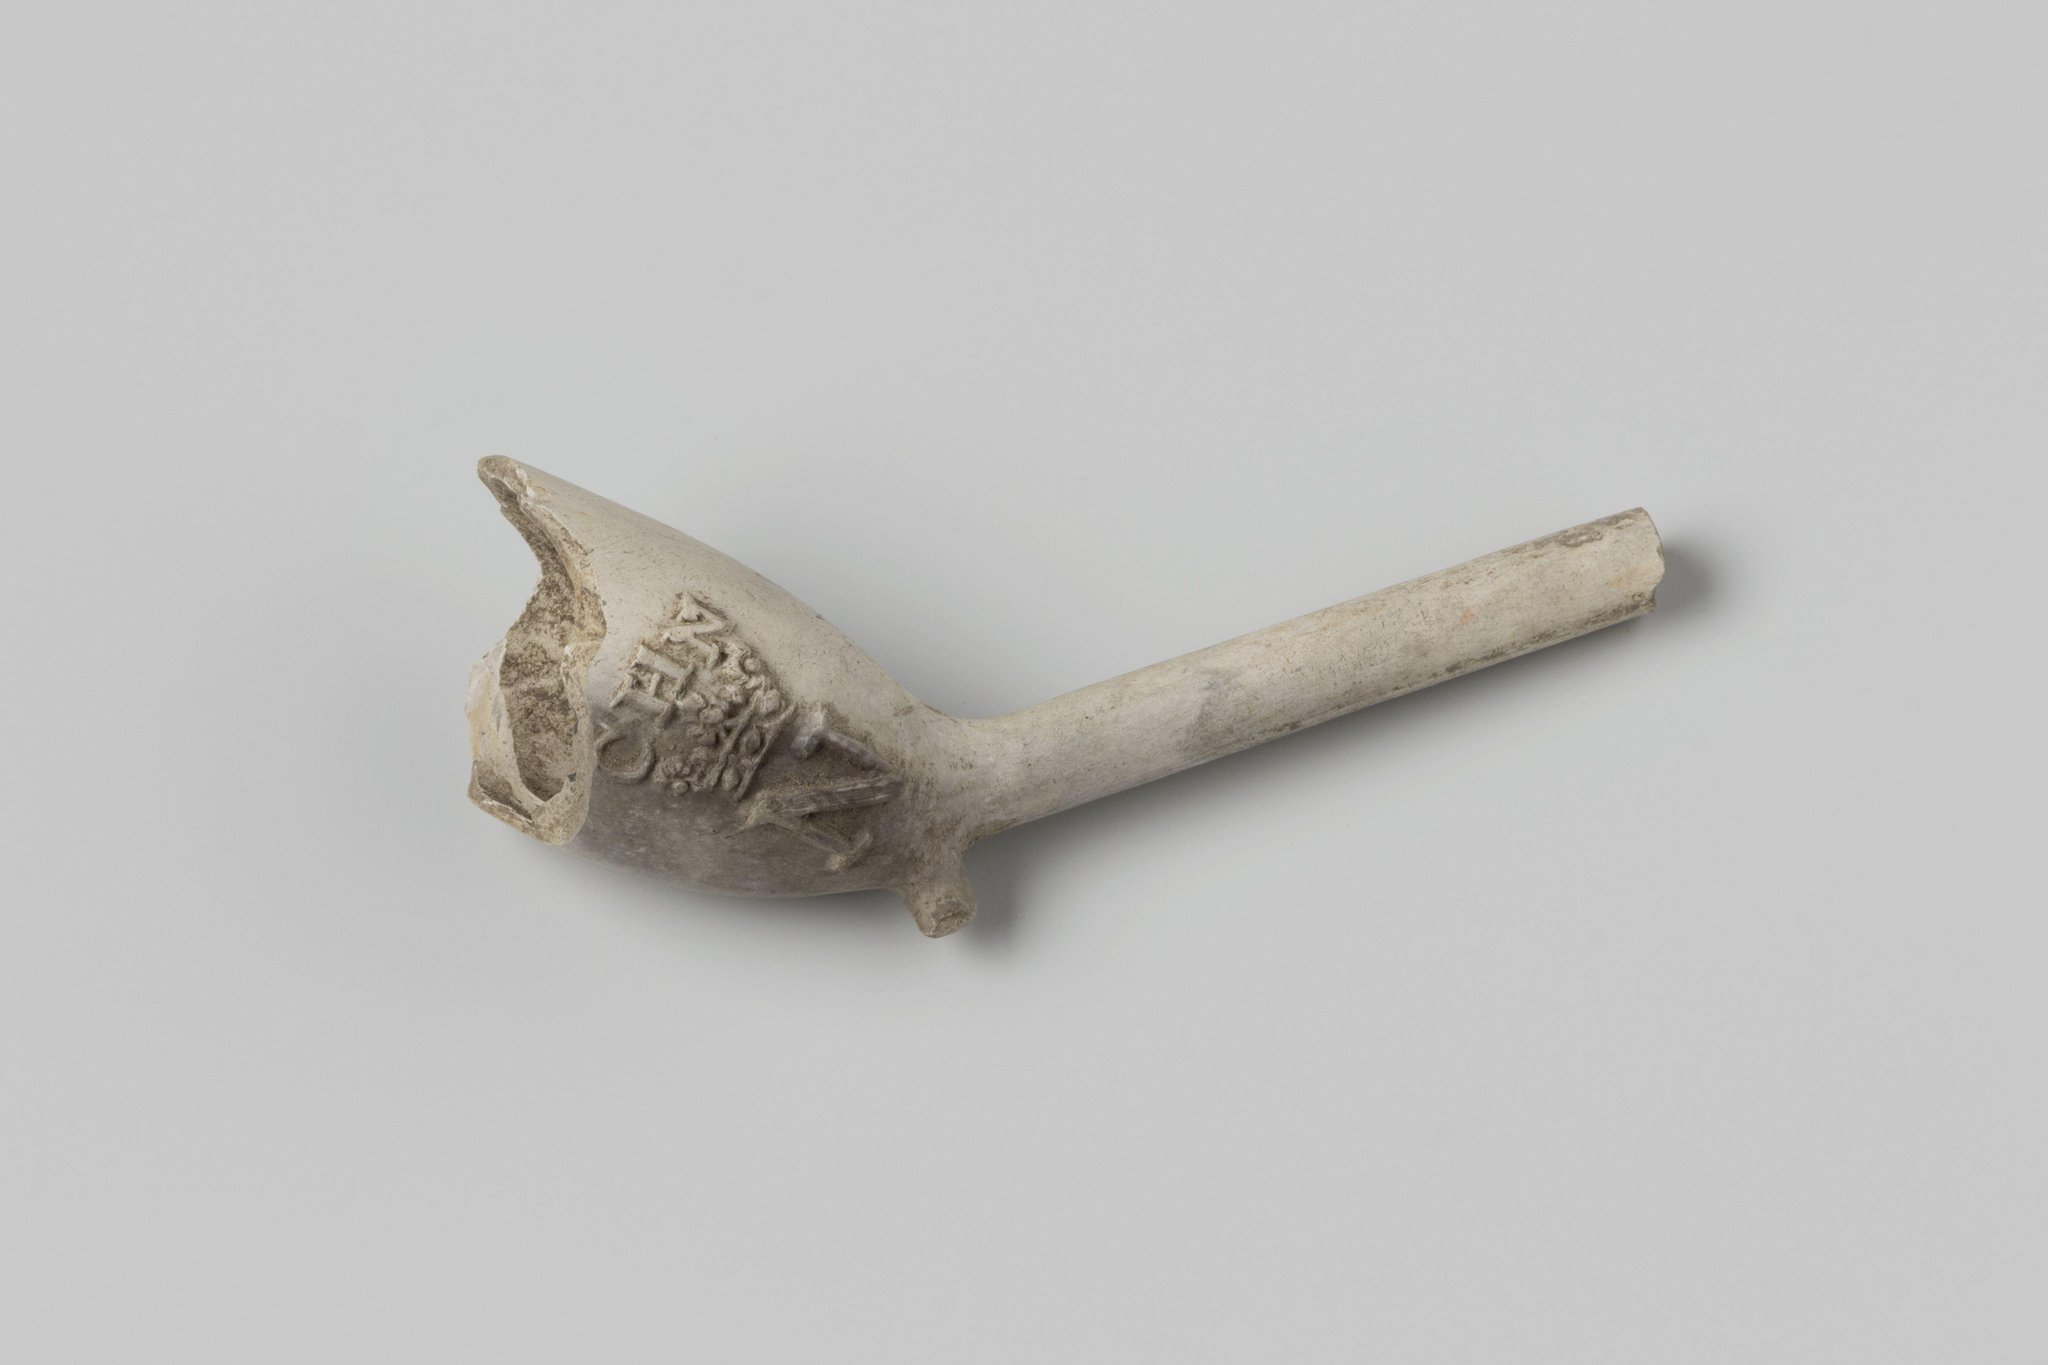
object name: pipe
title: Fragment tabakspijp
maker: cornelis huijvenaar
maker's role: pijpenfabrikant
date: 1760-1800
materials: clay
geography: schoonhoven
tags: directeur, hoogleraar, caspar jacob christiaan reuvens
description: Fragment tabakspijp met een kroon en de letters C H N en N afgebeeld. Van de opgravingen op de Hofstede Arentsburg 1827-1831 onder toezicht van Professor Reuvens.